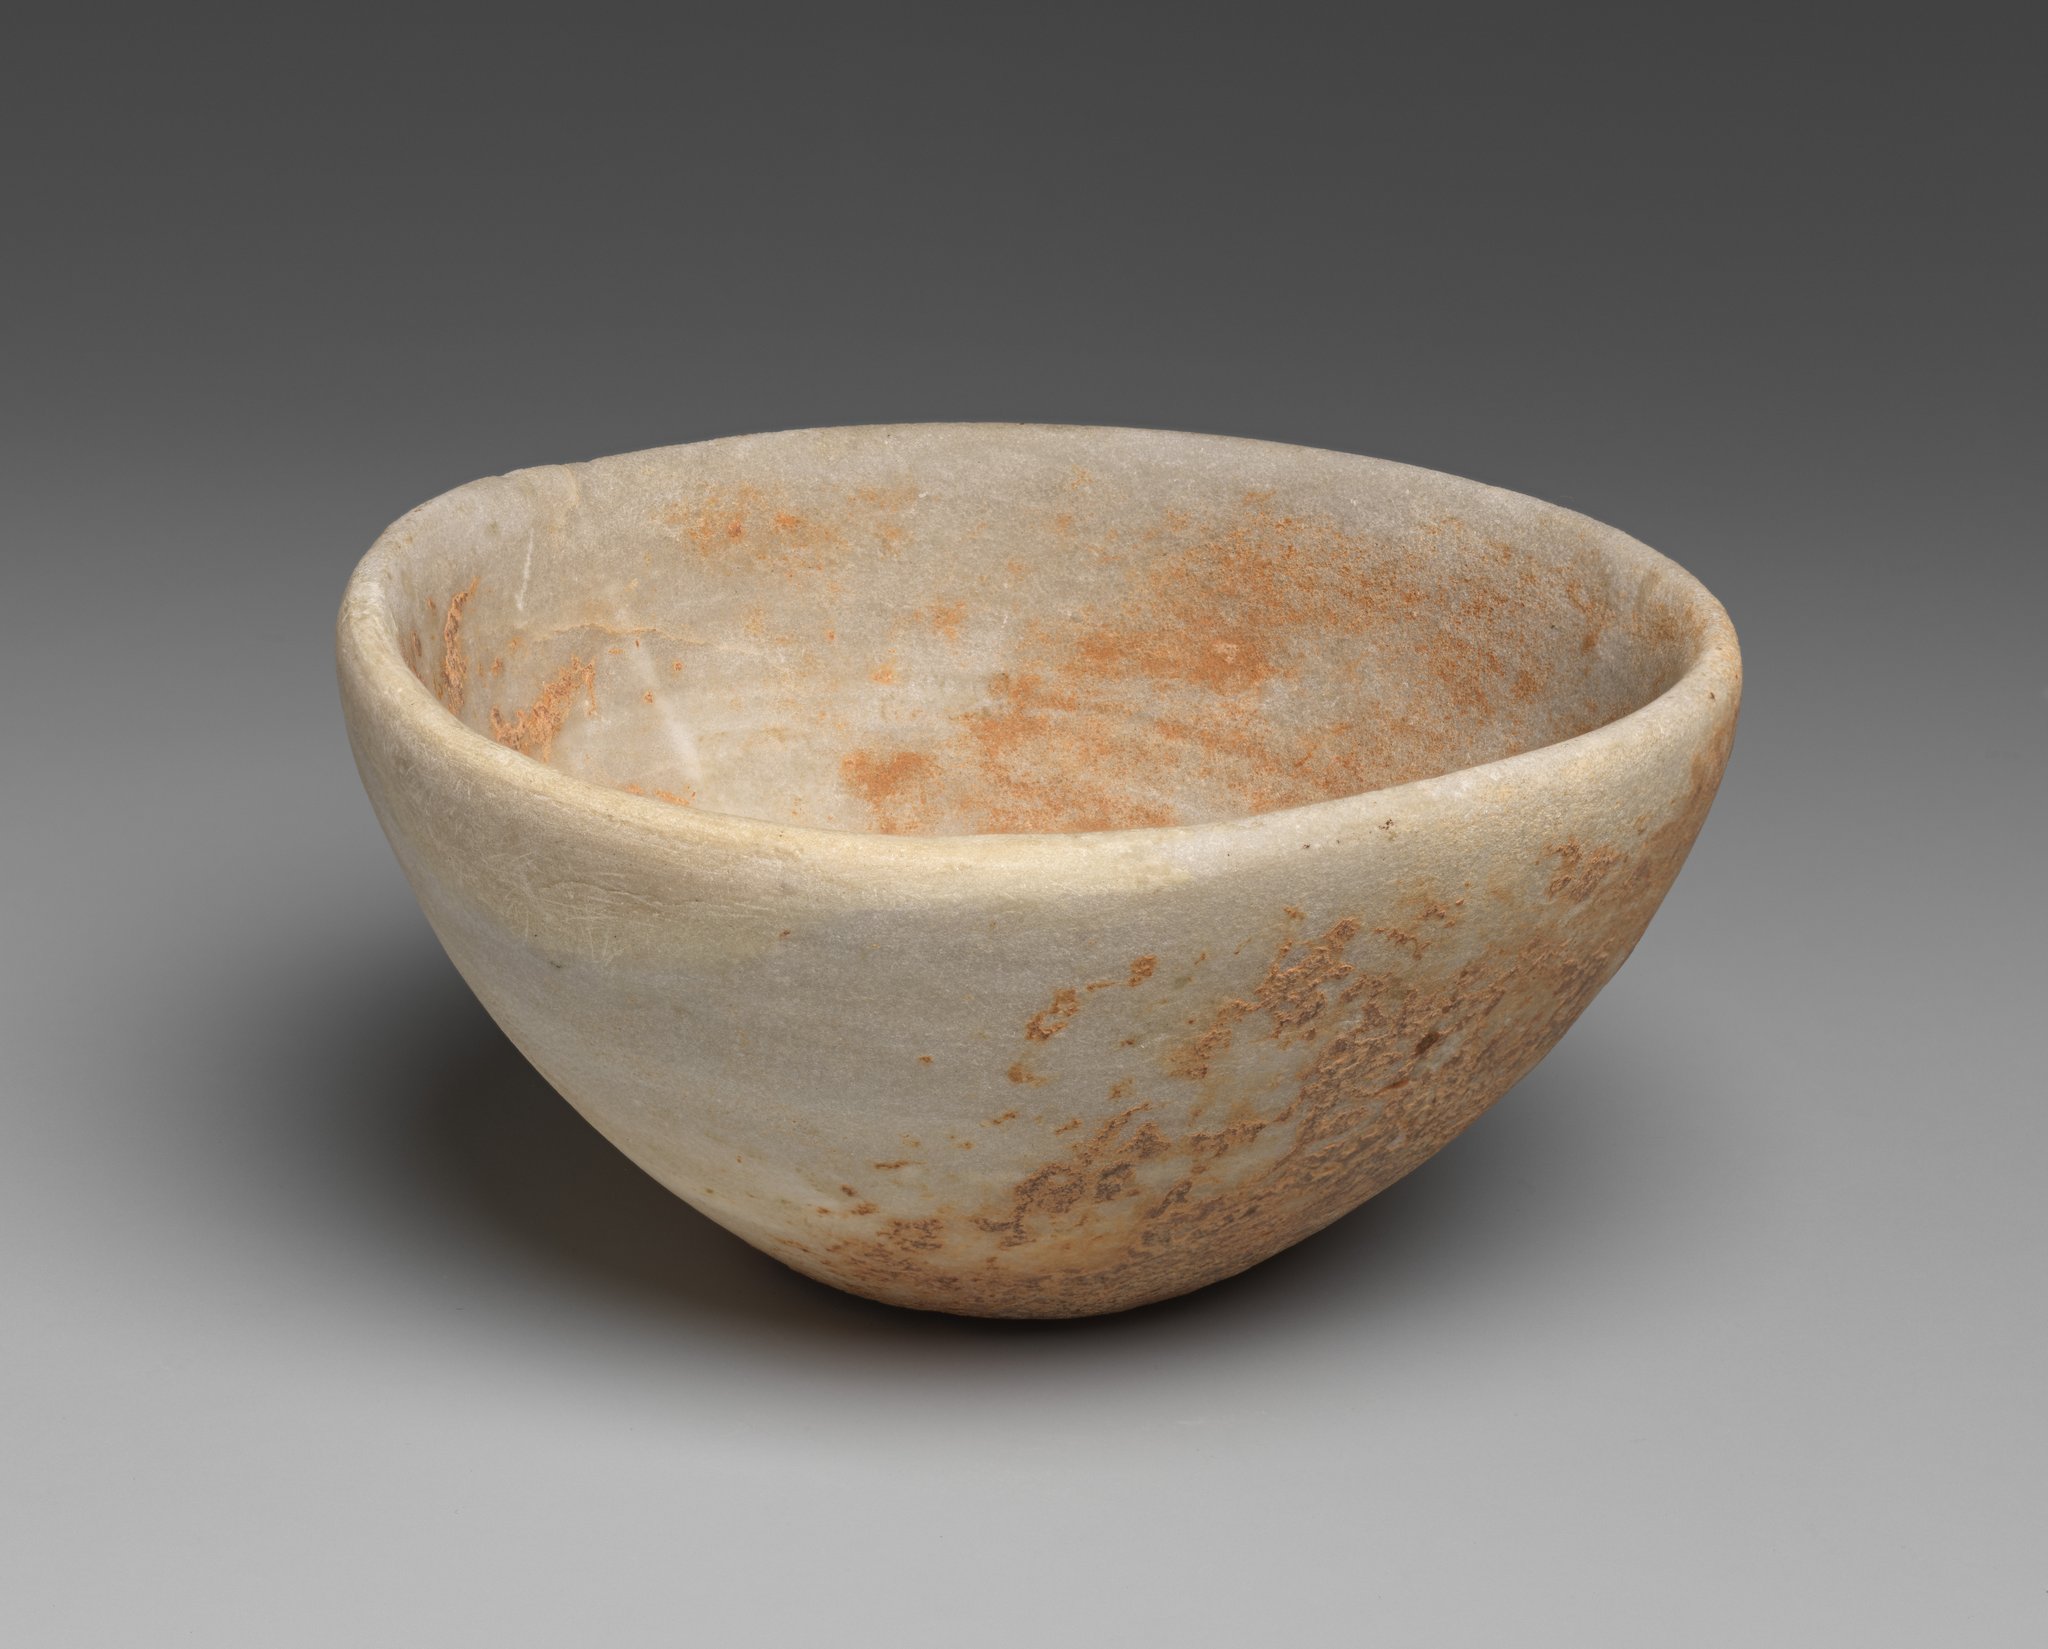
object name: bowl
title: Marble bowl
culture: cycladic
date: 2700-2200 BCE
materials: marble